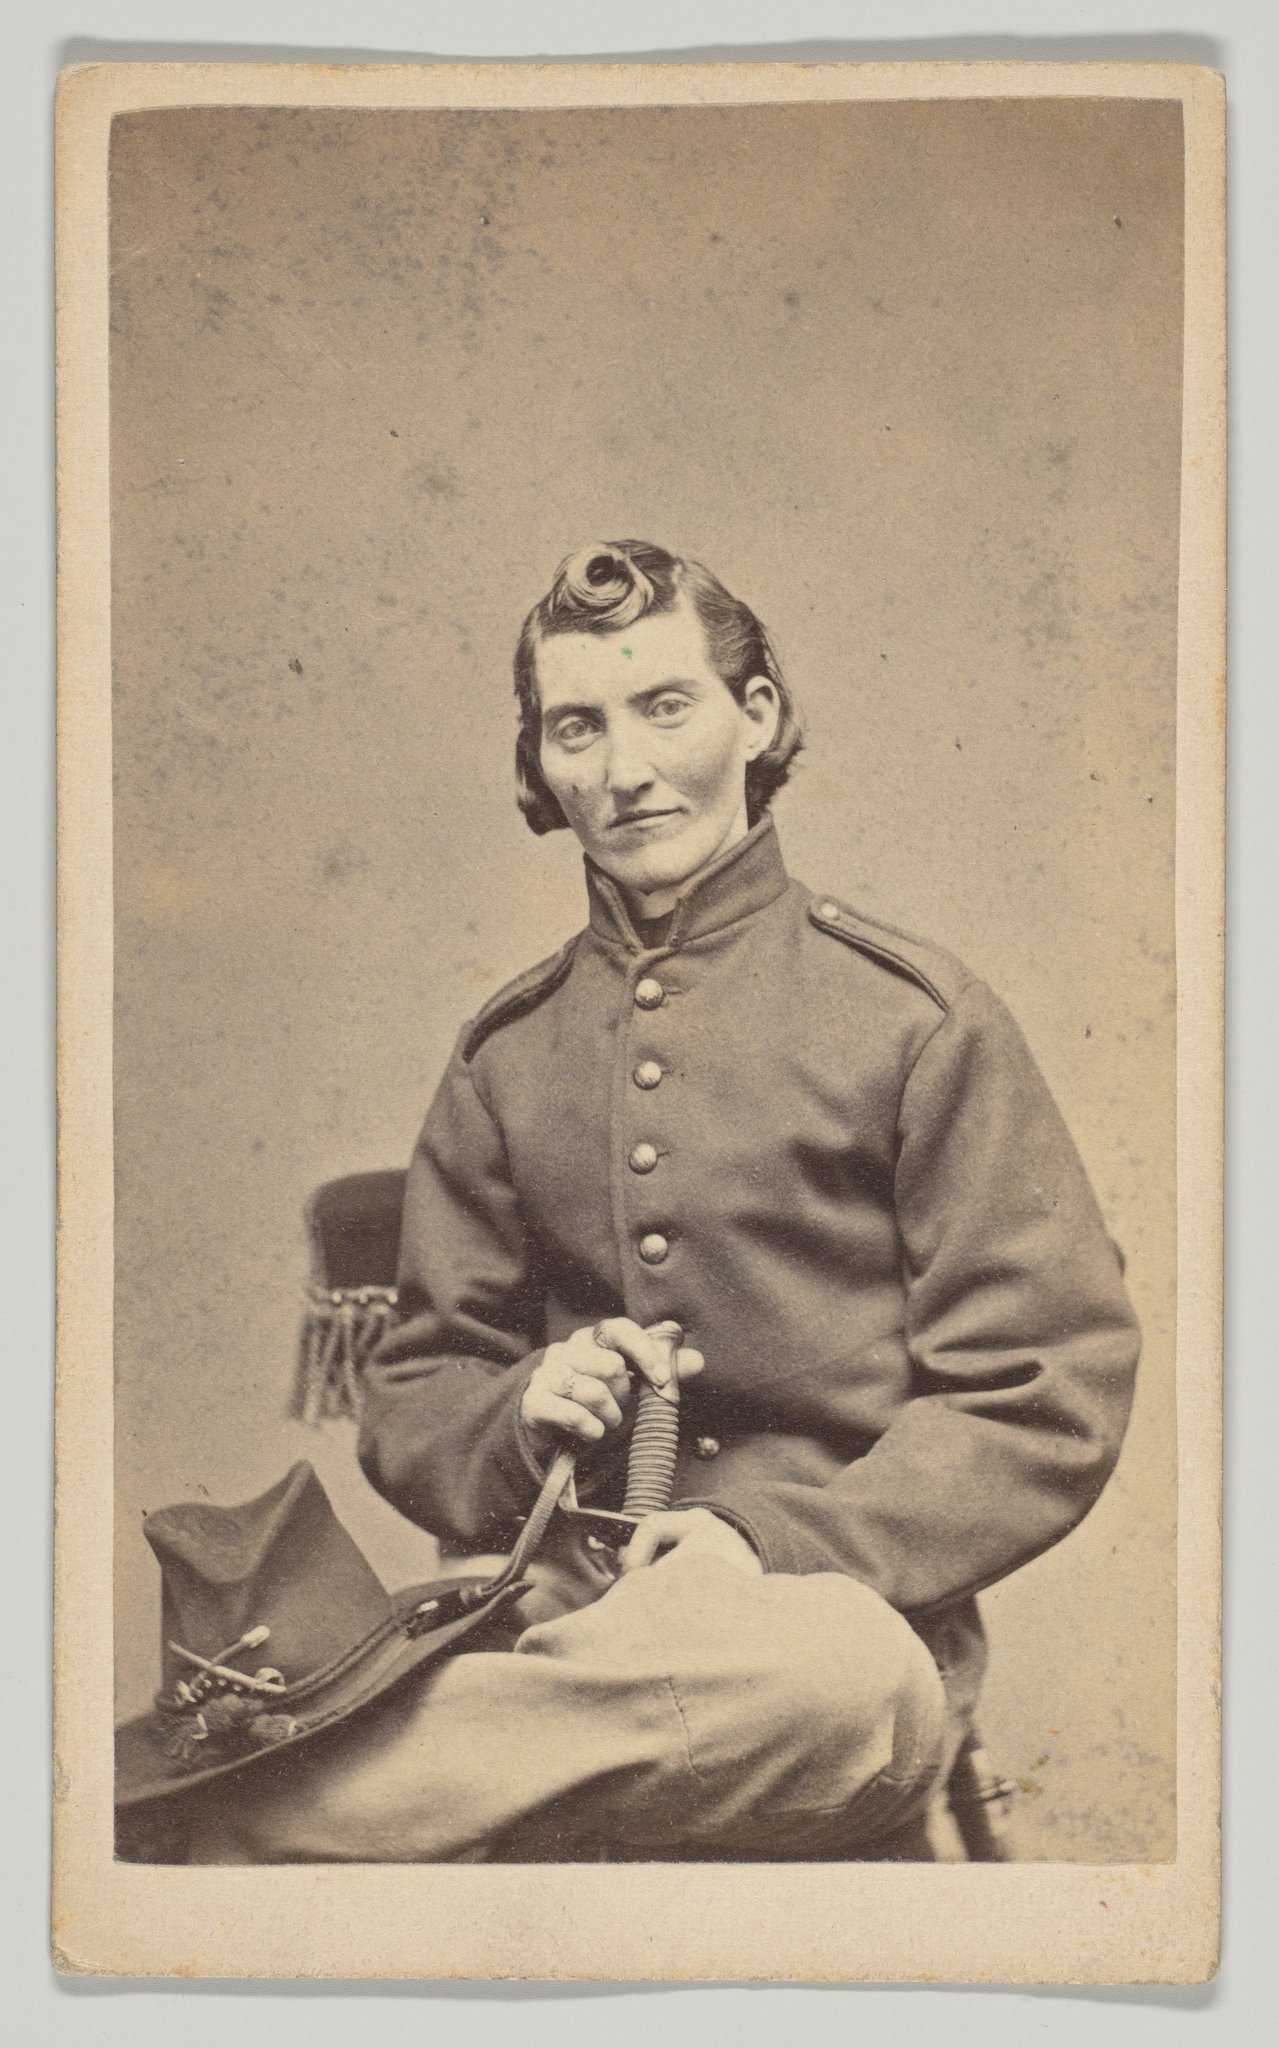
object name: carte de visite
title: Frances Clalin Clayton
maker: samuel masury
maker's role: artist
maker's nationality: american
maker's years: 1818-1874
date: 1864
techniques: albumen silver print, glass negative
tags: american civil war,portraits,women